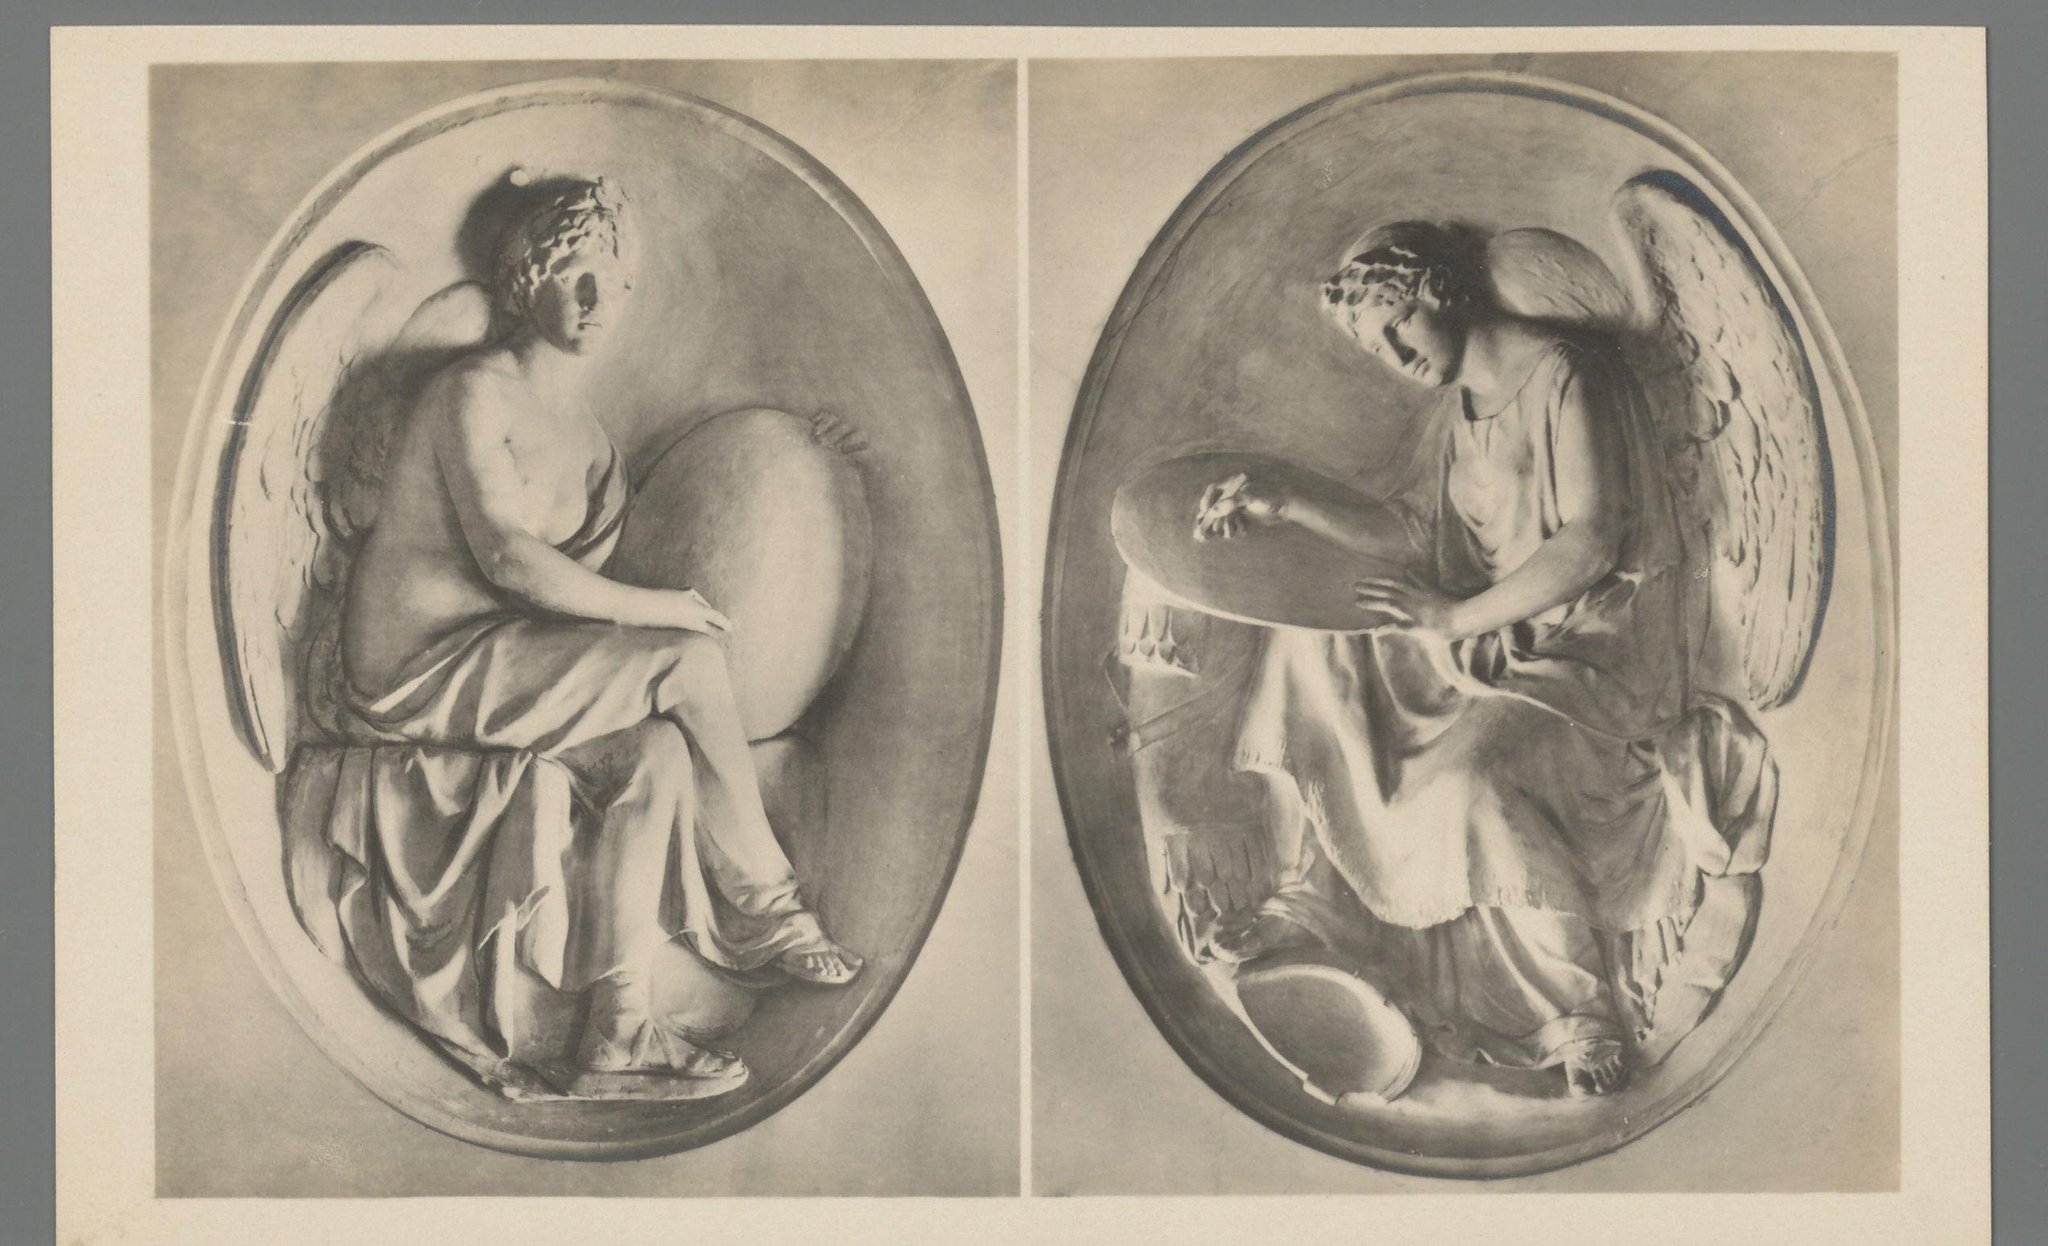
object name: photograph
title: Berlin, Schloss. Königskammern, Parolesaal Reliefs (Schadow)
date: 1905-1930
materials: photographic support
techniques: photography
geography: berlin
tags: castle, interior of the house, decorating 'en relief', appliquéing